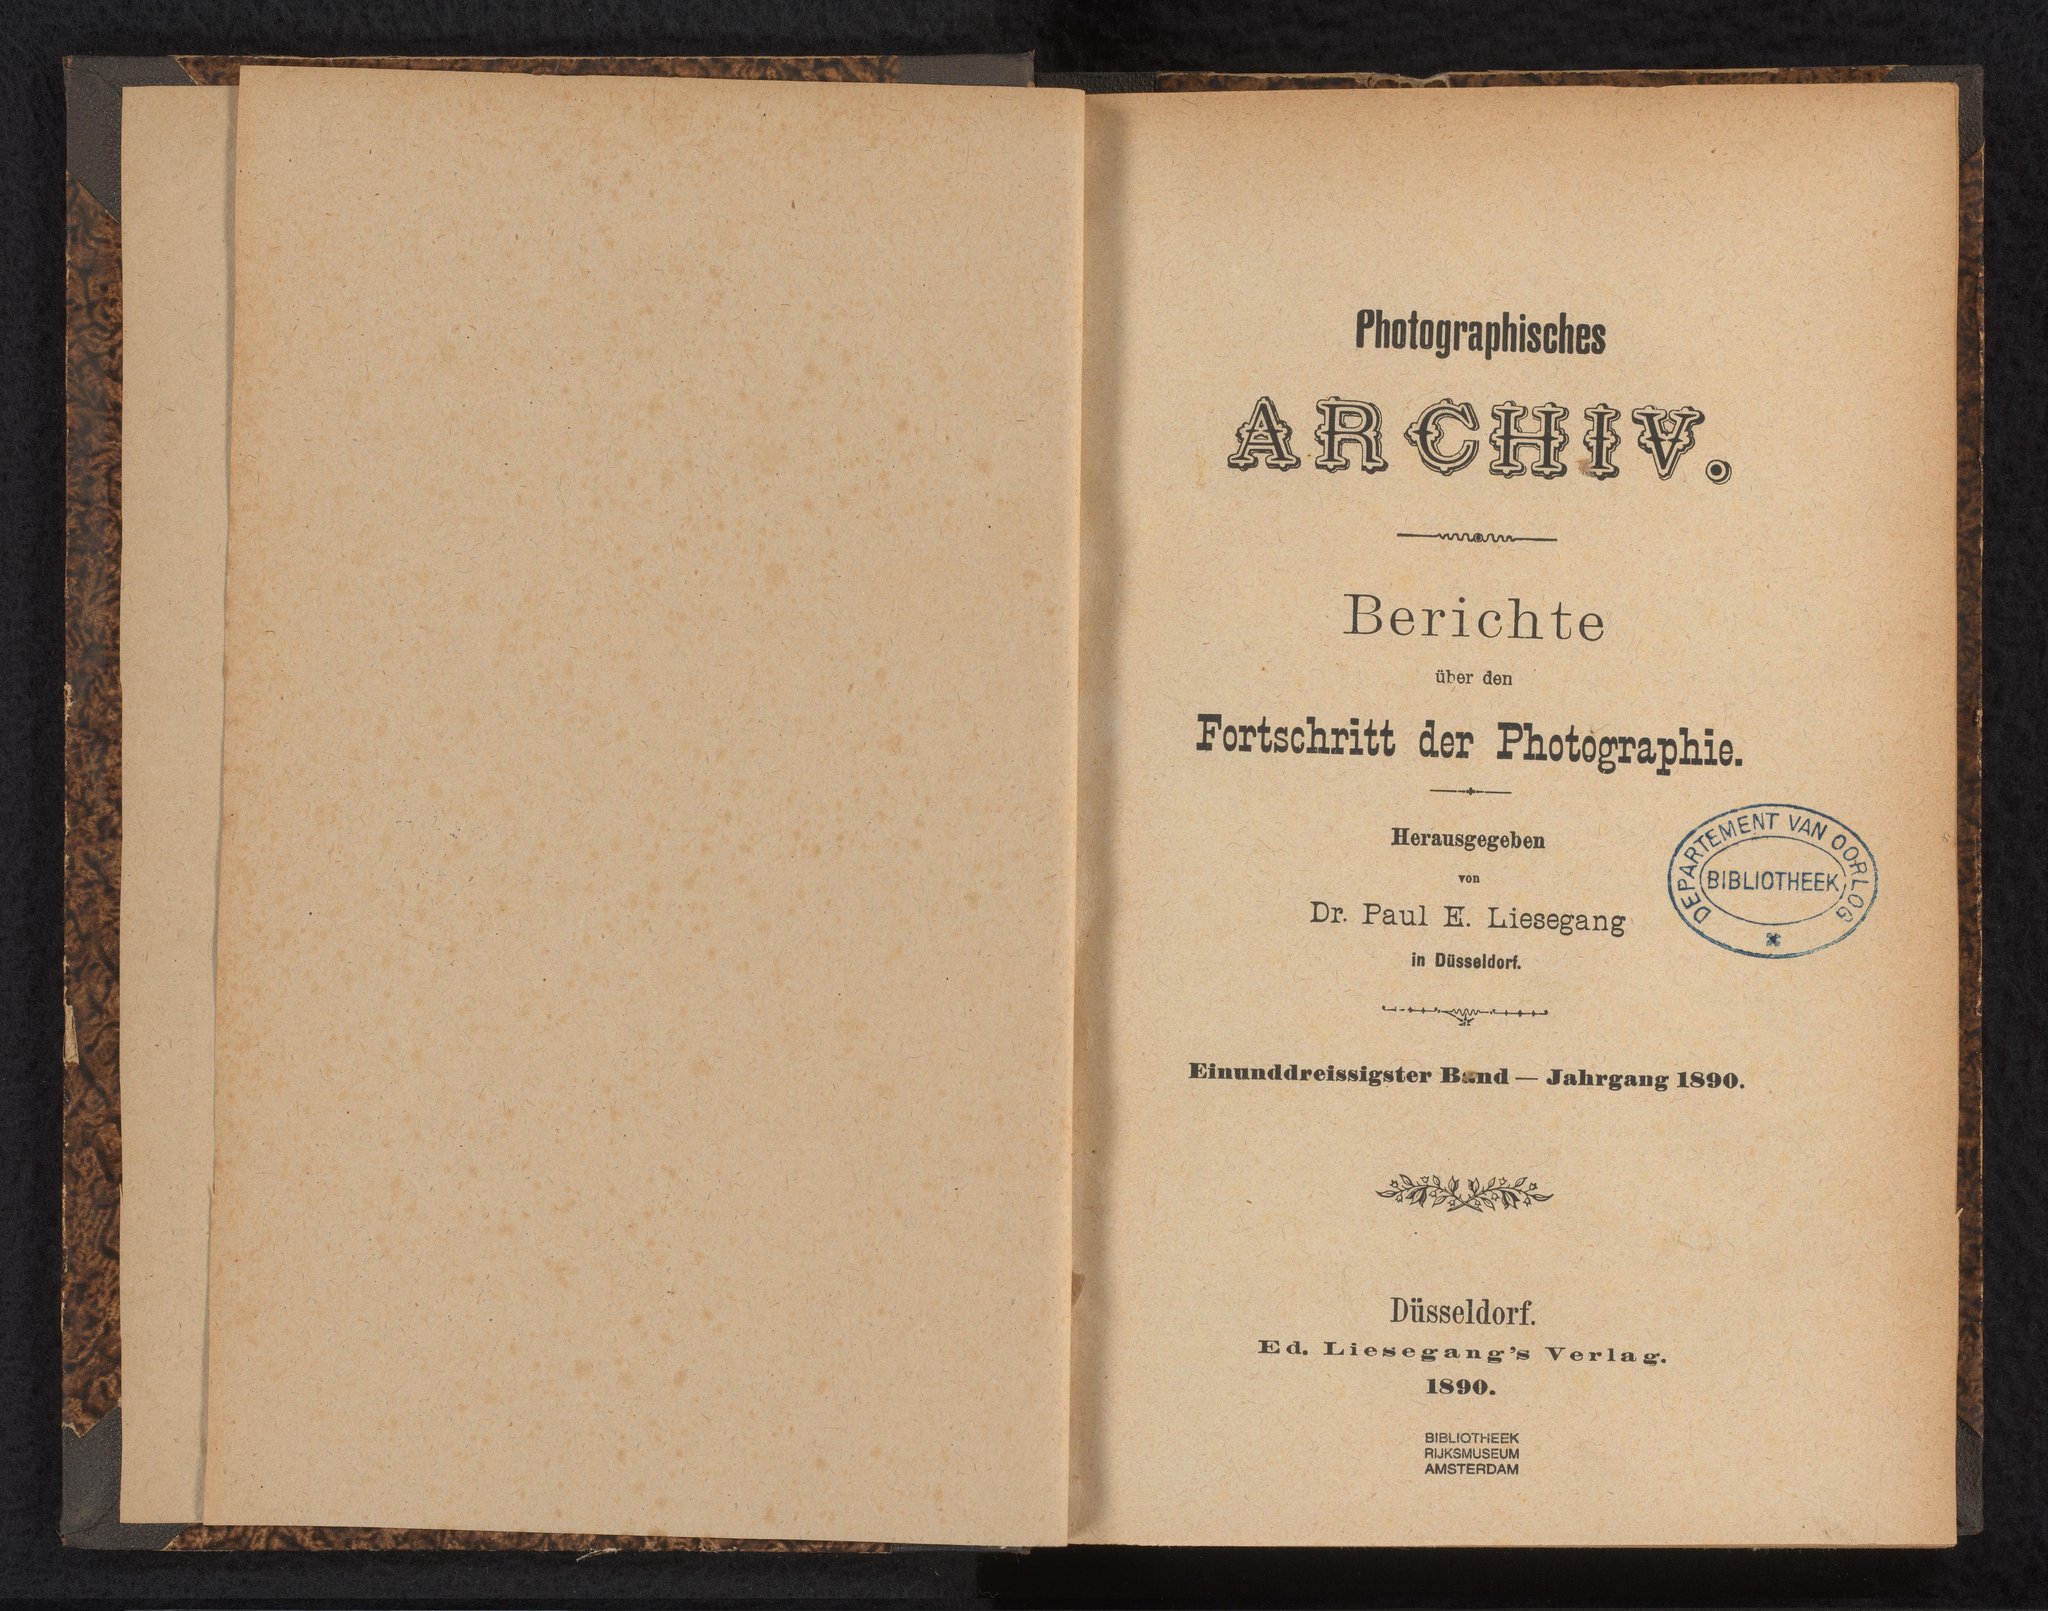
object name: book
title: Photographisches Archiv. Einunddreissigster Band - Jahrgang 1890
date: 1890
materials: cardboard, linen, paper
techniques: photograph, engraving, letterpress printing, photolithography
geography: dusseldorf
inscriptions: stamp: ‘Departement/ Bibliotheek/ van oorlog.’, stamp: ‘Departement van oorlog/ Bibliotheek’